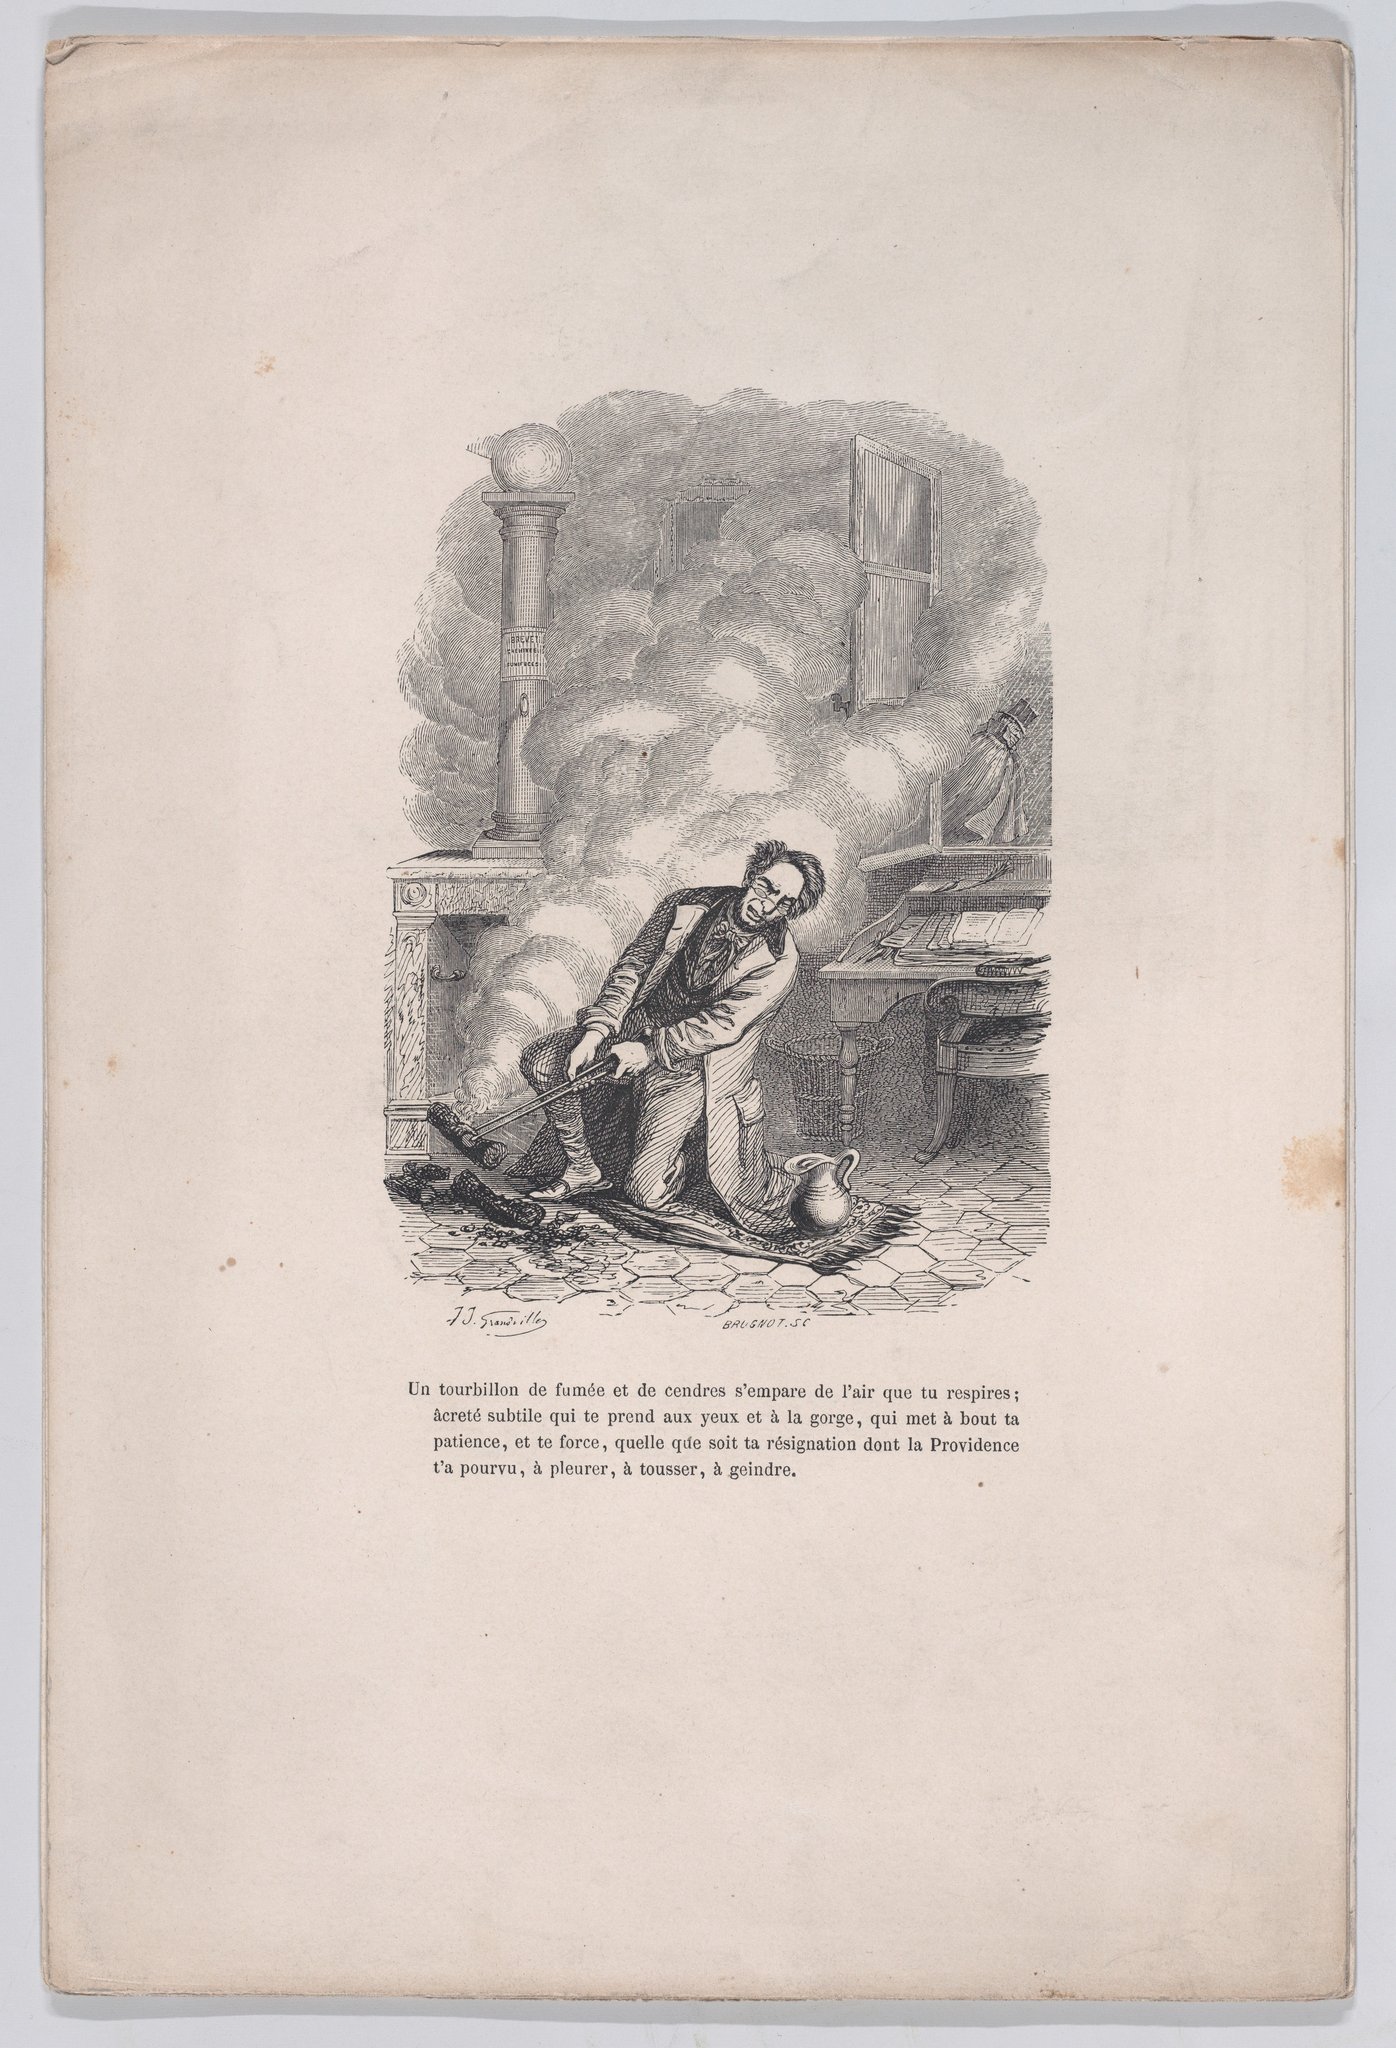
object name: print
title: A whirlwind of smoke and ashes seizes the air you breathe, from "Little Miseries of Human Life"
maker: j. j. grandville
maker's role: illustrator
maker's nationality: french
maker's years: 1803-1847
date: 1843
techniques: engraving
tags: men